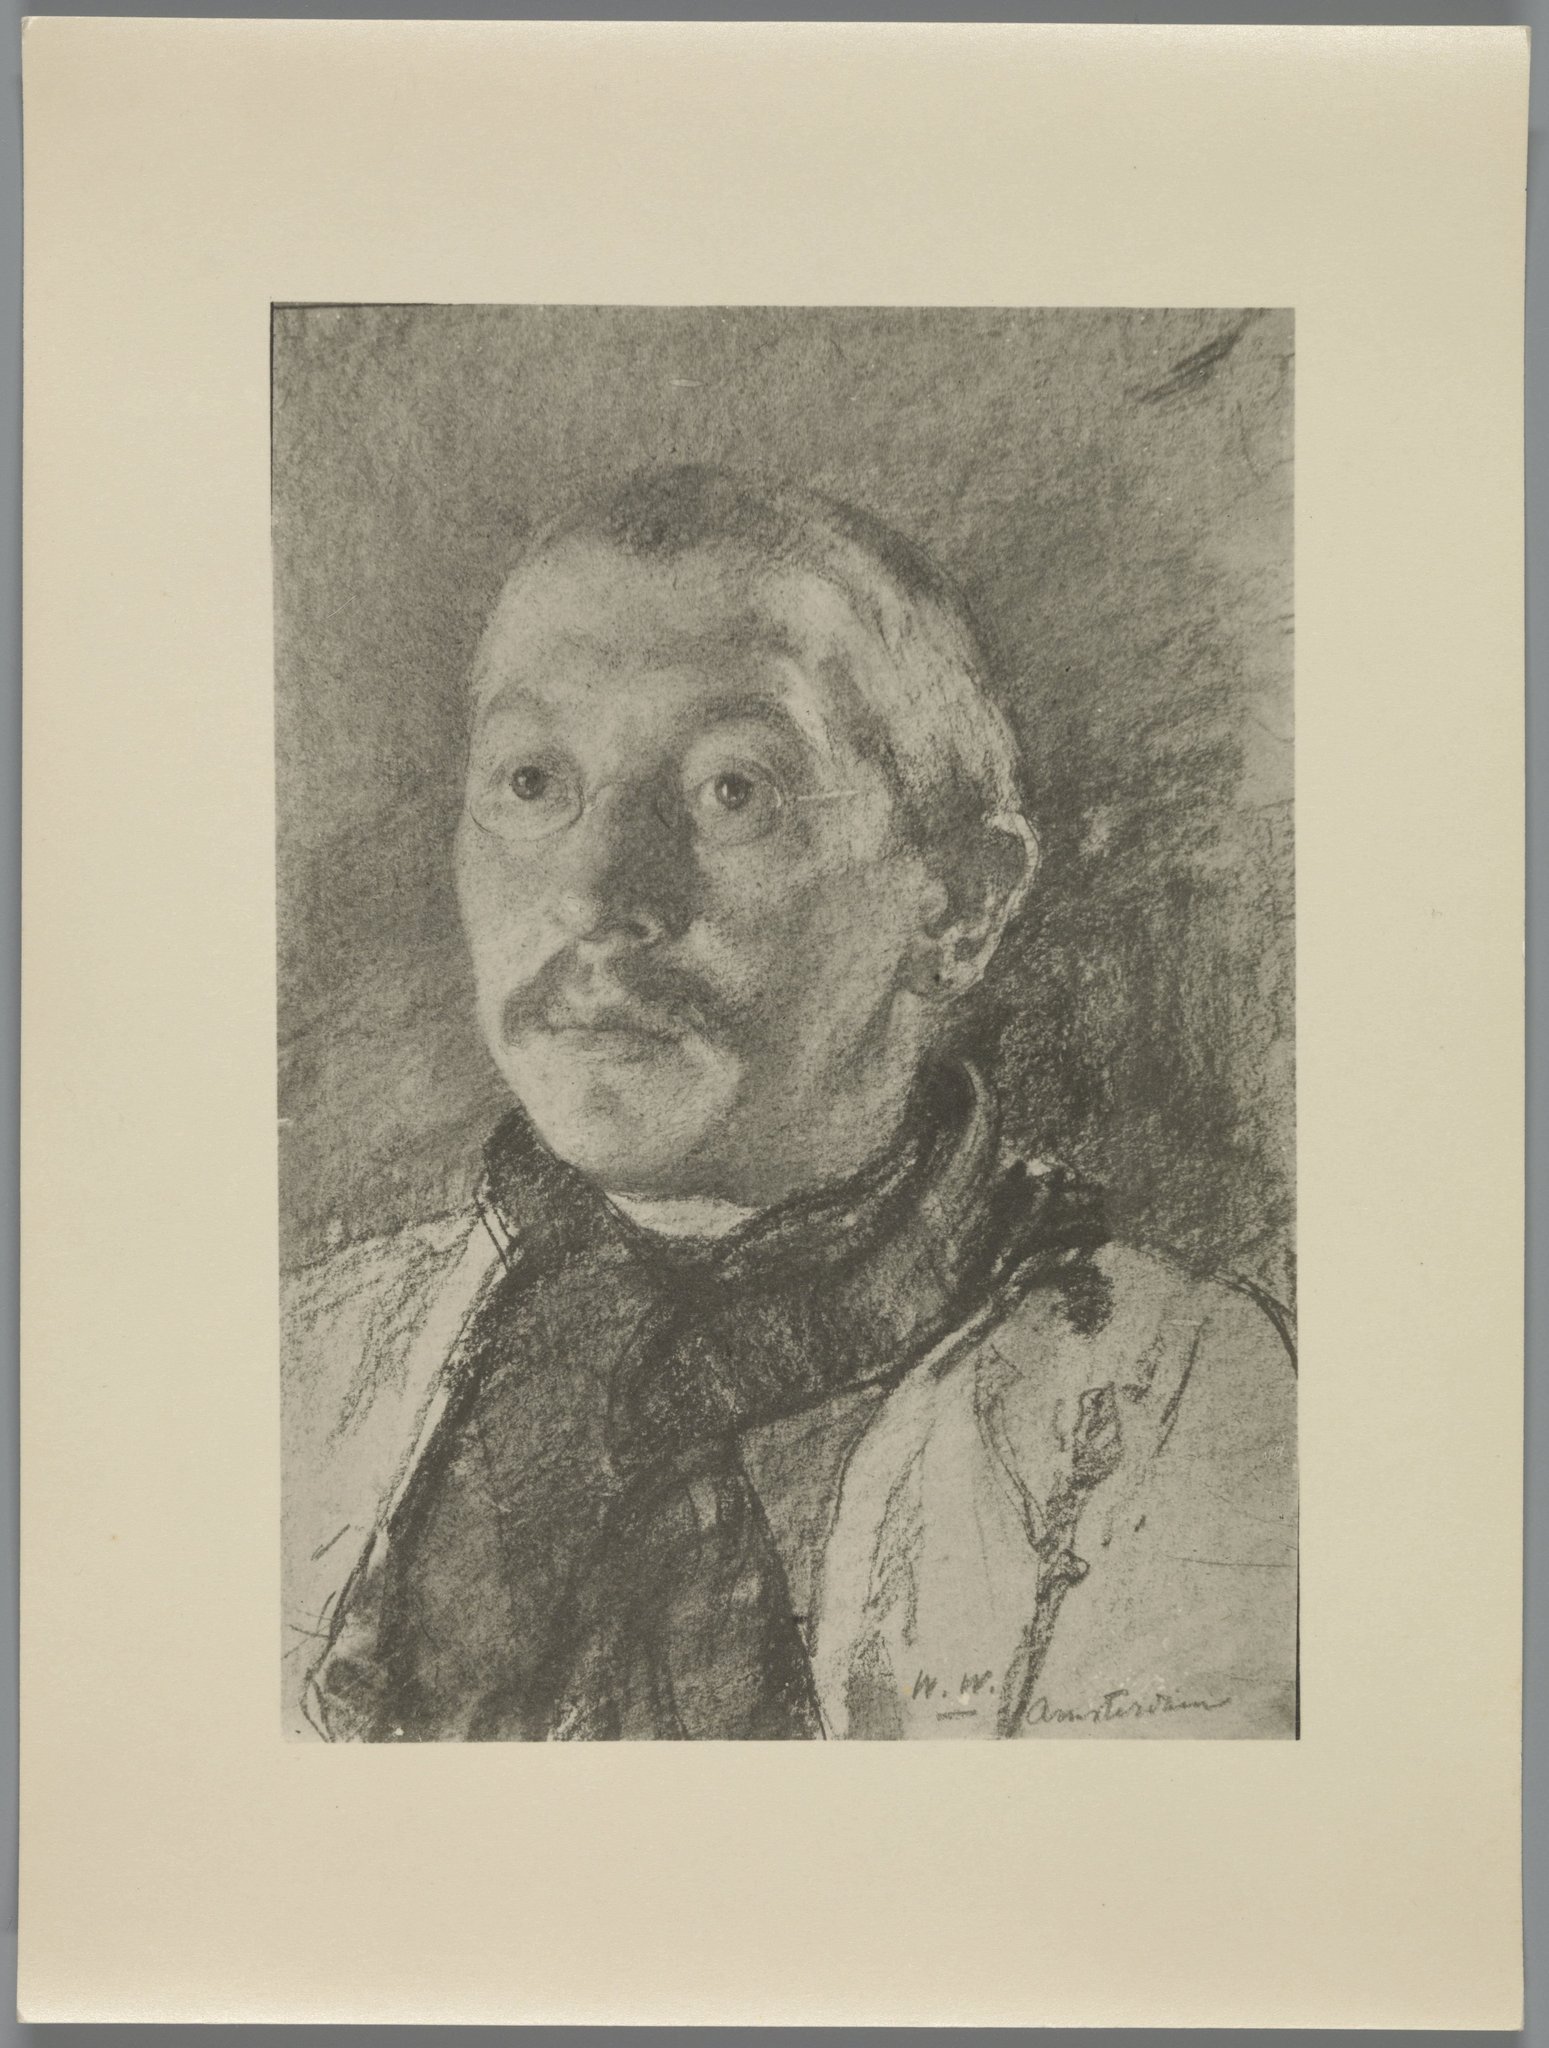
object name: photograph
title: Reproductie naar een foto van Willem Witsen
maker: Anonymous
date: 1860-1915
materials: paper, photographic support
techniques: gelatin silver print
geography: netherlands